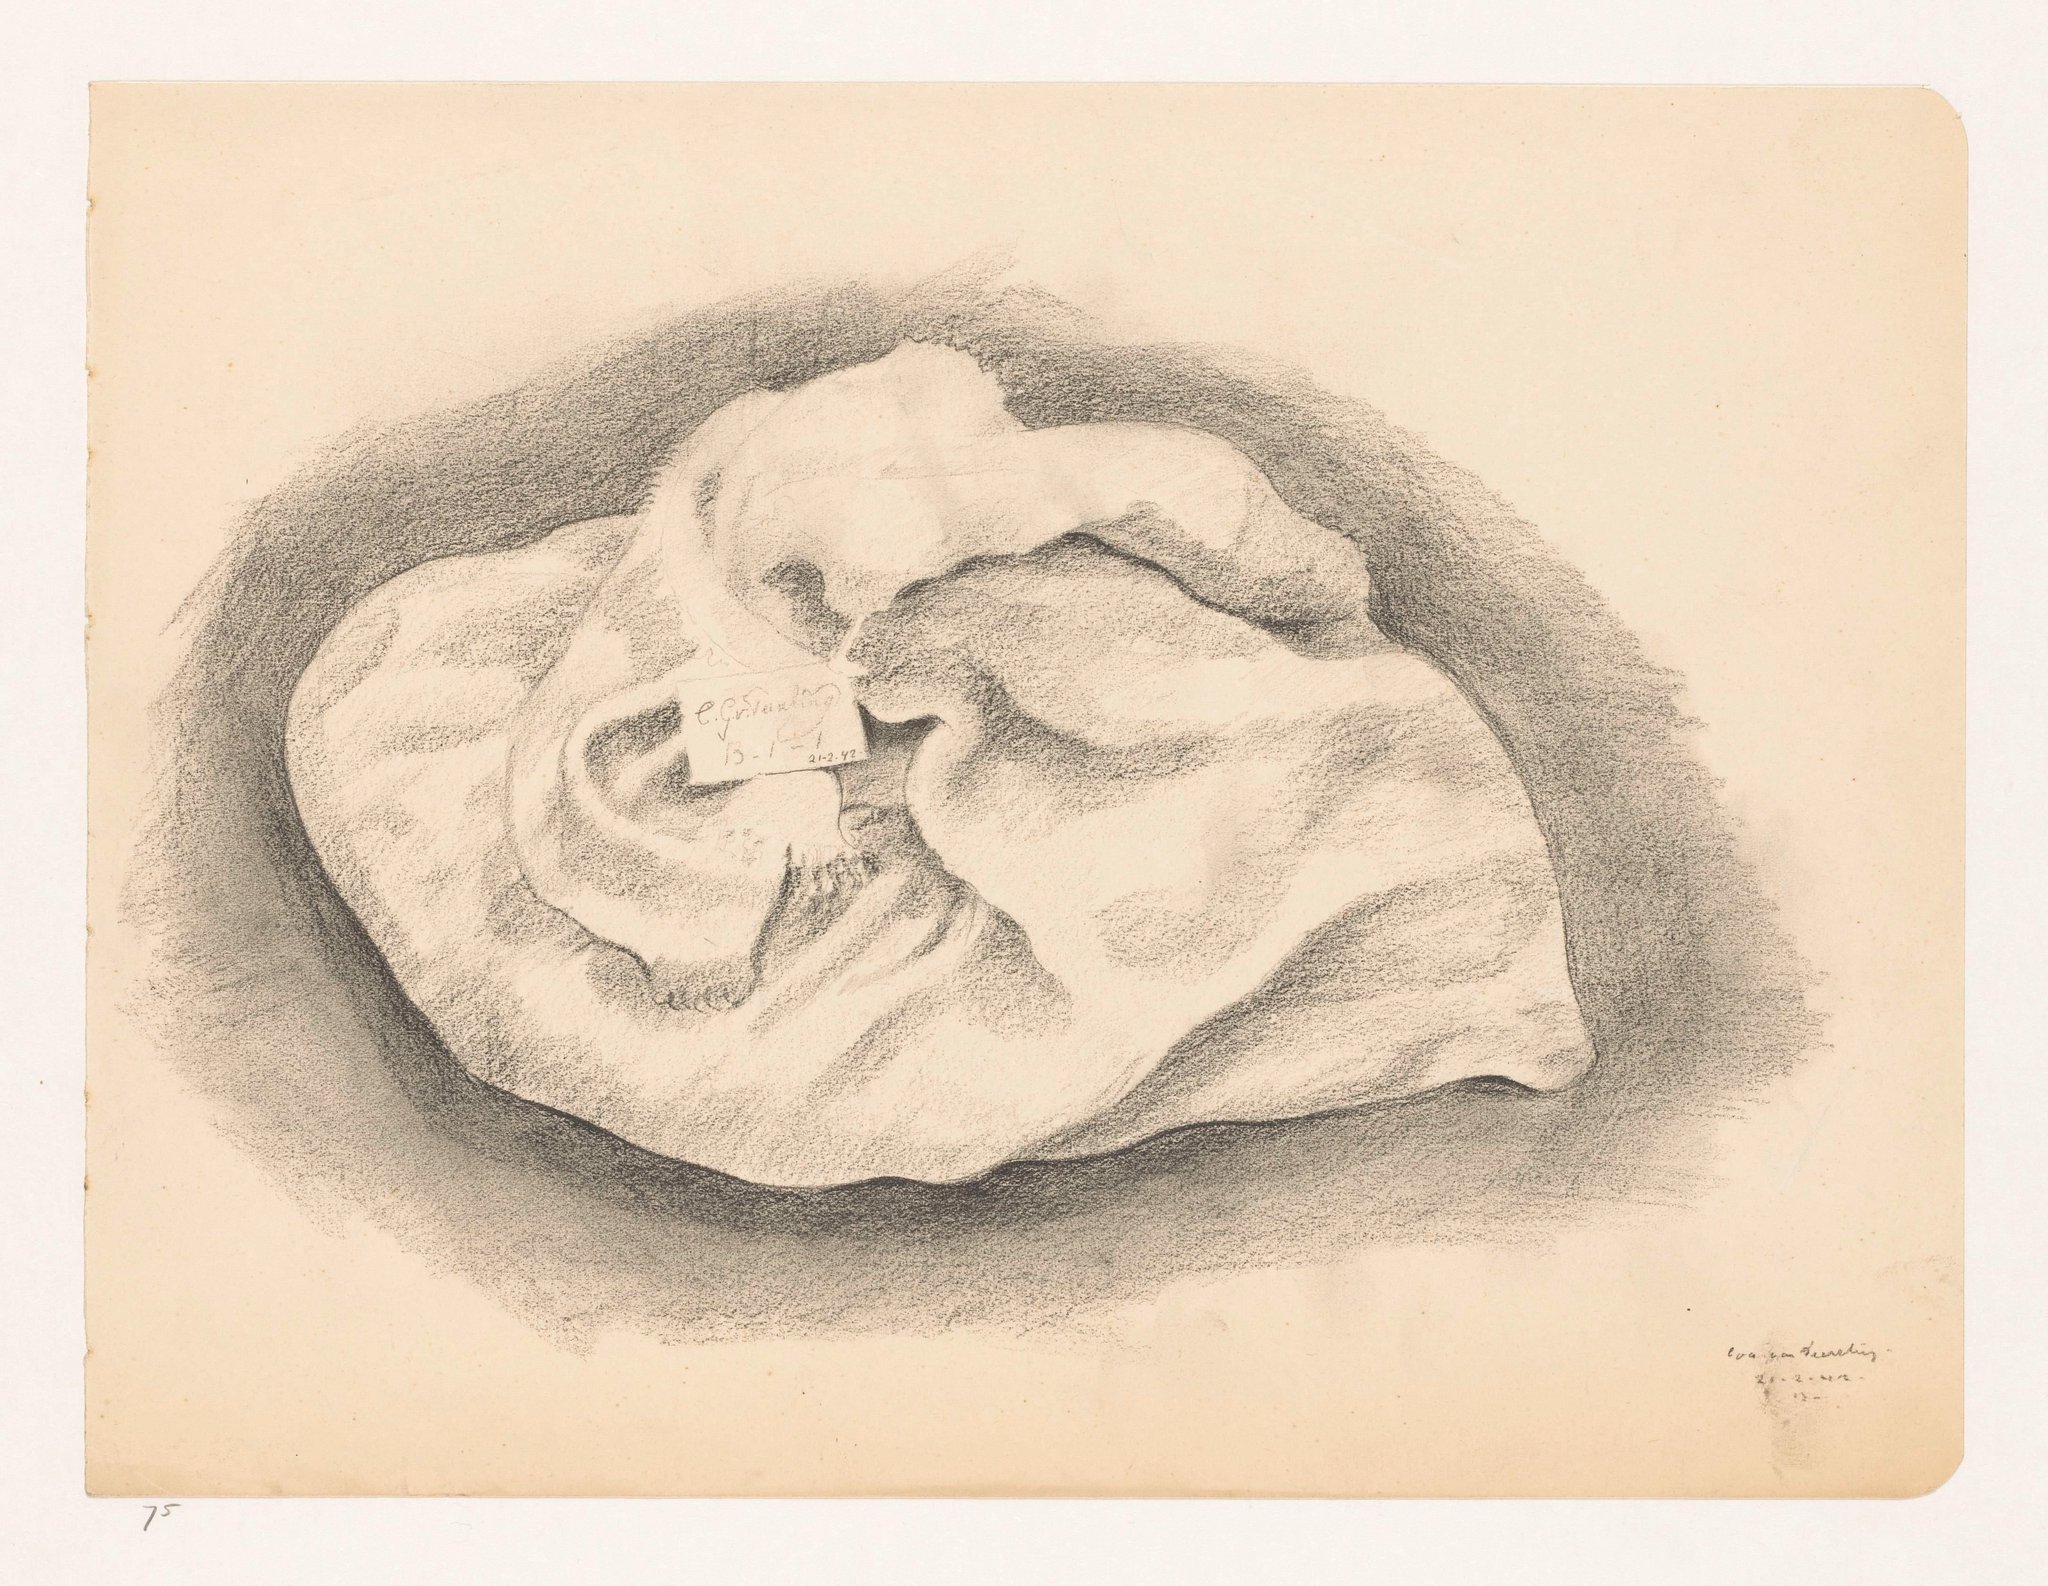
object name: drawing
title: Wasgoed met briefje C.G. van Teesling B-1-1 21-2-42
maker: cor van teeseling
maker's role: draughtsman, sculptor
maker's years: 1915-1942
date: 1942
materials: chalk, paper, pencil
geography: weteringschans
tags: amsterdam, draughtsman, sculptor, cor van teeseling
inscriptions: signature and date: ‘Cor van Teeseling / 12-2-1942 / B-’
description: Wasgoed met briefje C.G. van Teesling B-1-1 21-2-42.